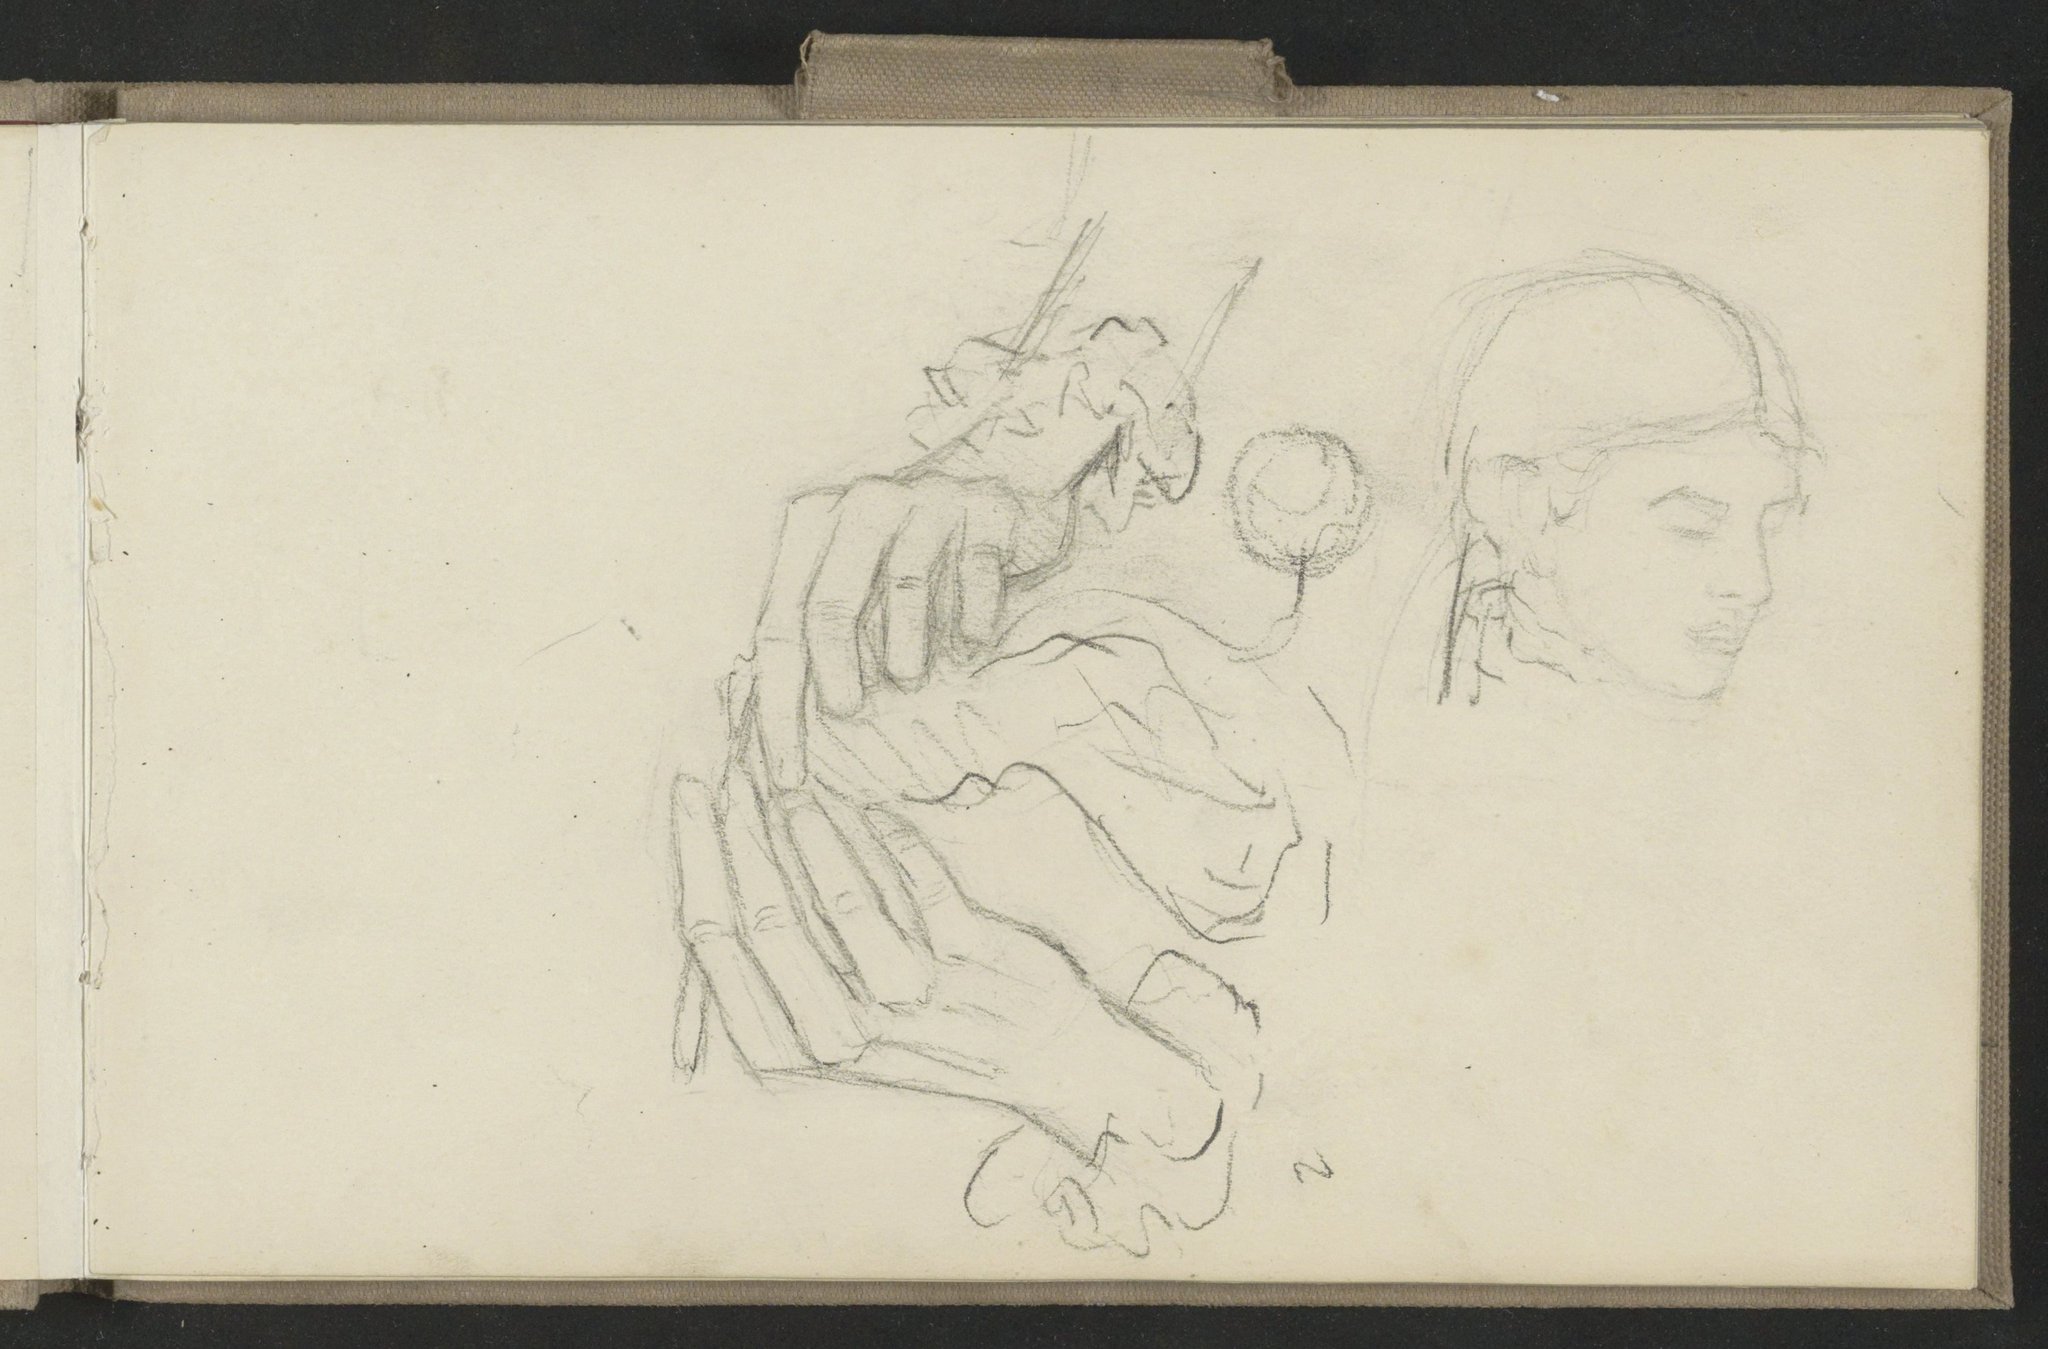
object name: sketchbook leaf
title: Handen met een breiwerk en een kop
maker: jozef israëls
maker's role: draughtsman, painter, print maker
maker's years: 1824-1911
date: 1834-1911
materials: paper, pencil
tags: head (human), hand, knitting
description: Blad 2 recto uit een schetsboek met 26 bladen.